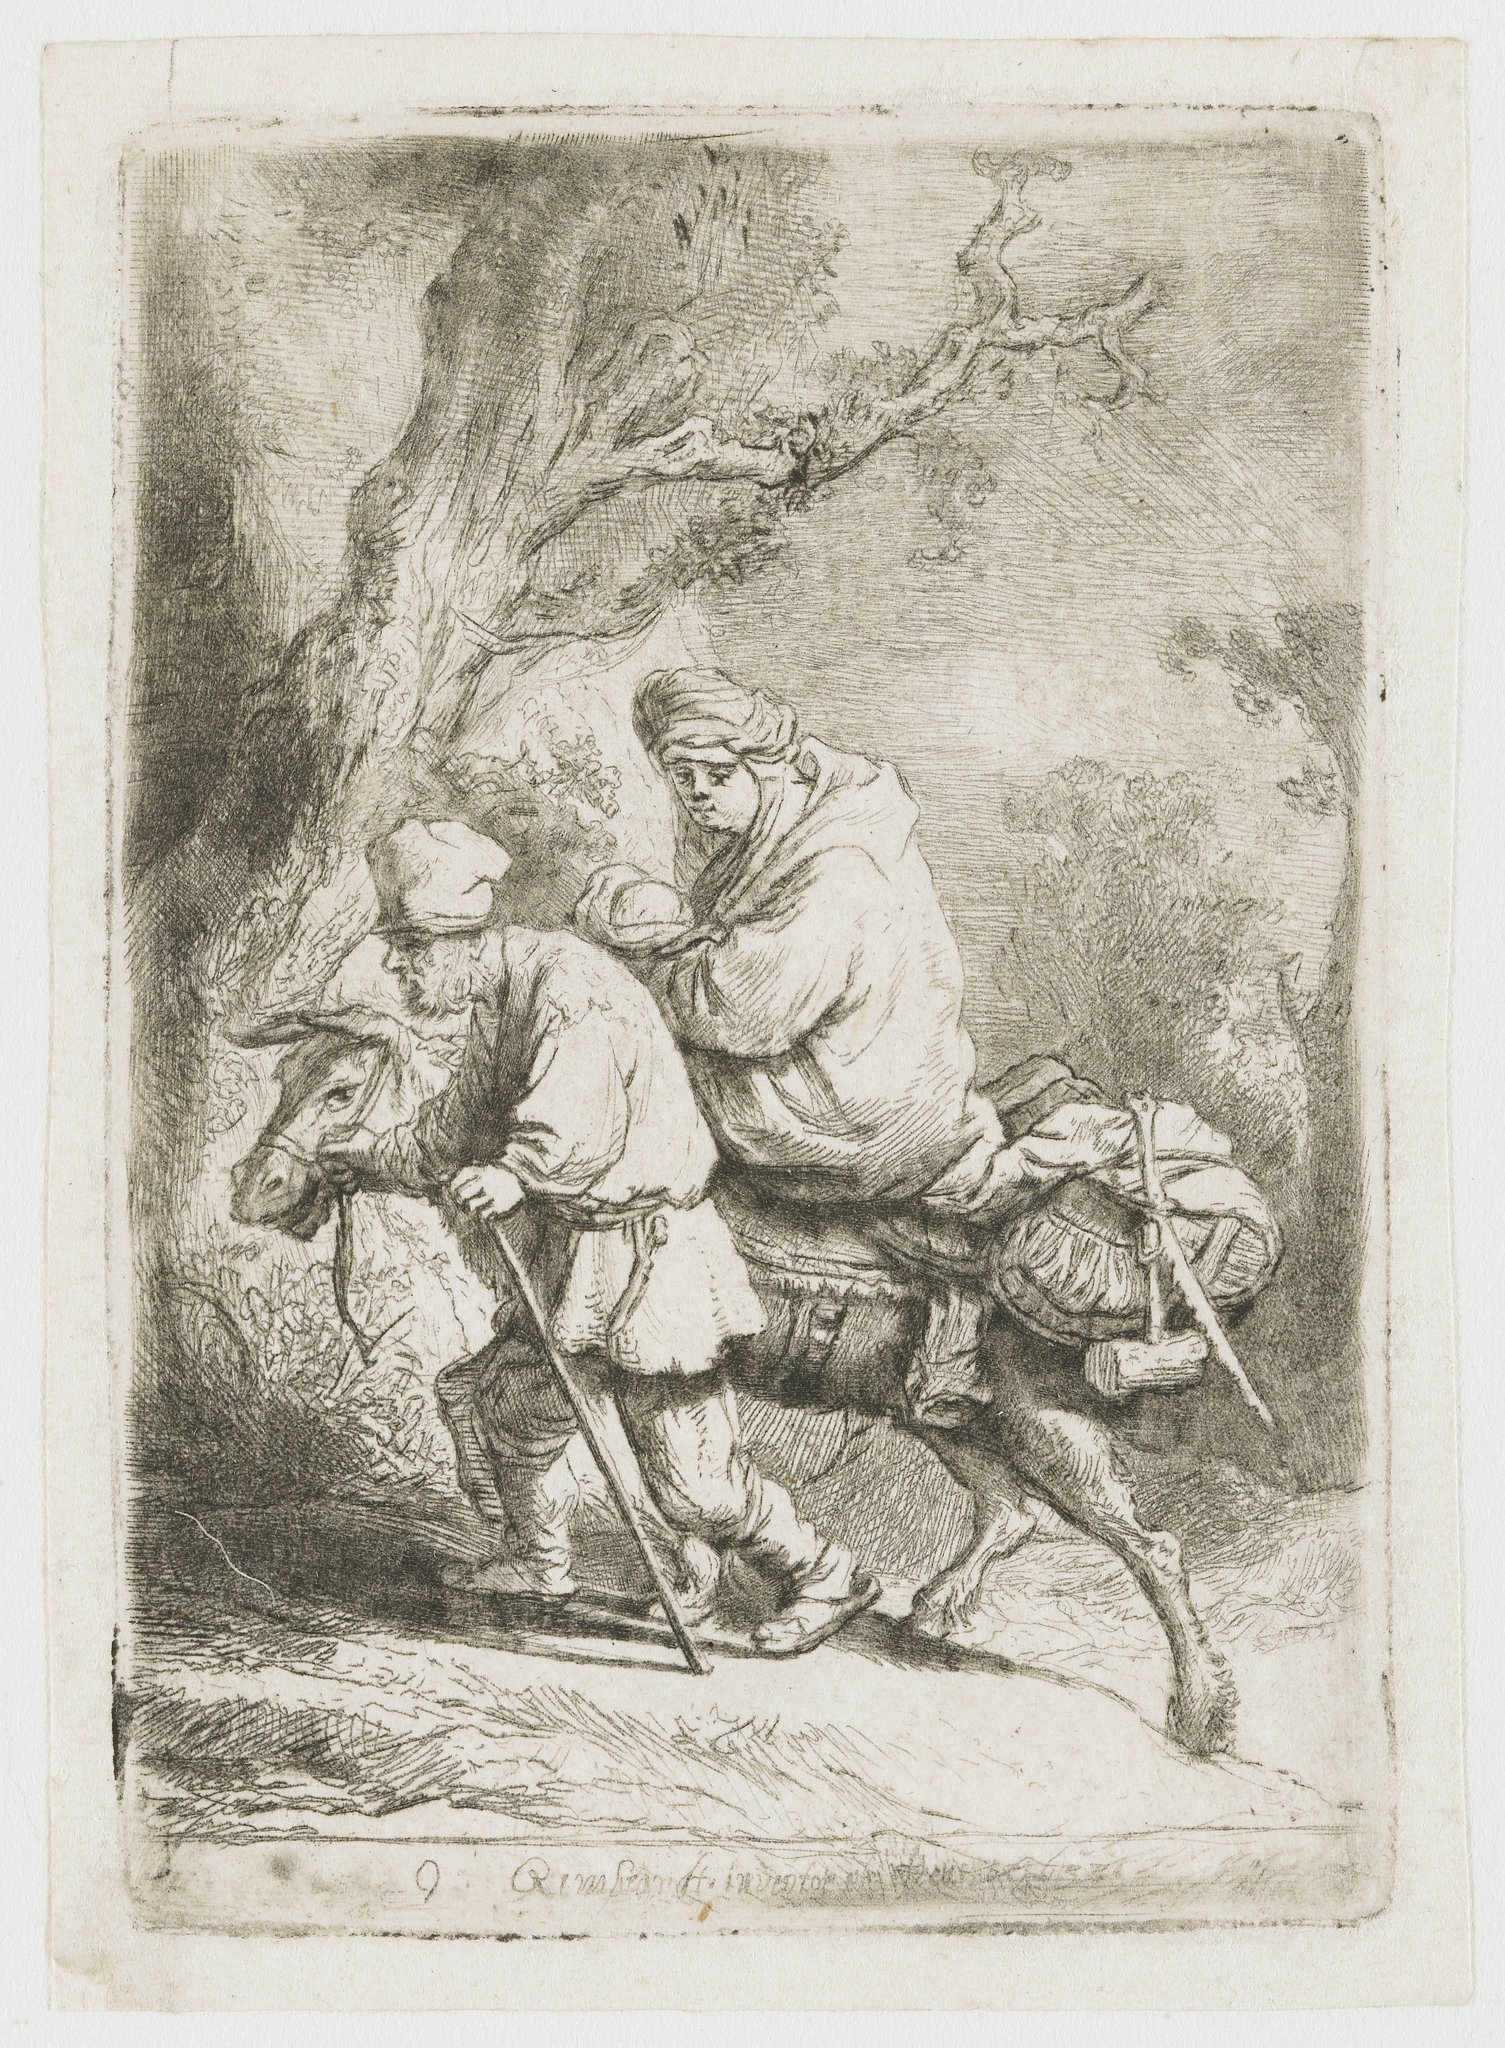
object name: print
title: The flight into Egypt: small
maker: rembrandt van rijn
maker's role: draughtsman, painter, print maker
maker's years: 1606-1669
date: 1633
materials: paper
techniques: etching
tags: the flight into egypt: mary, joseph, the child (and sometimes others) on their way; mary usually riding on an ass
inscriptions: number: ‘9’, signature and date: ‘Rembrandt.inventor et fecit.1633’